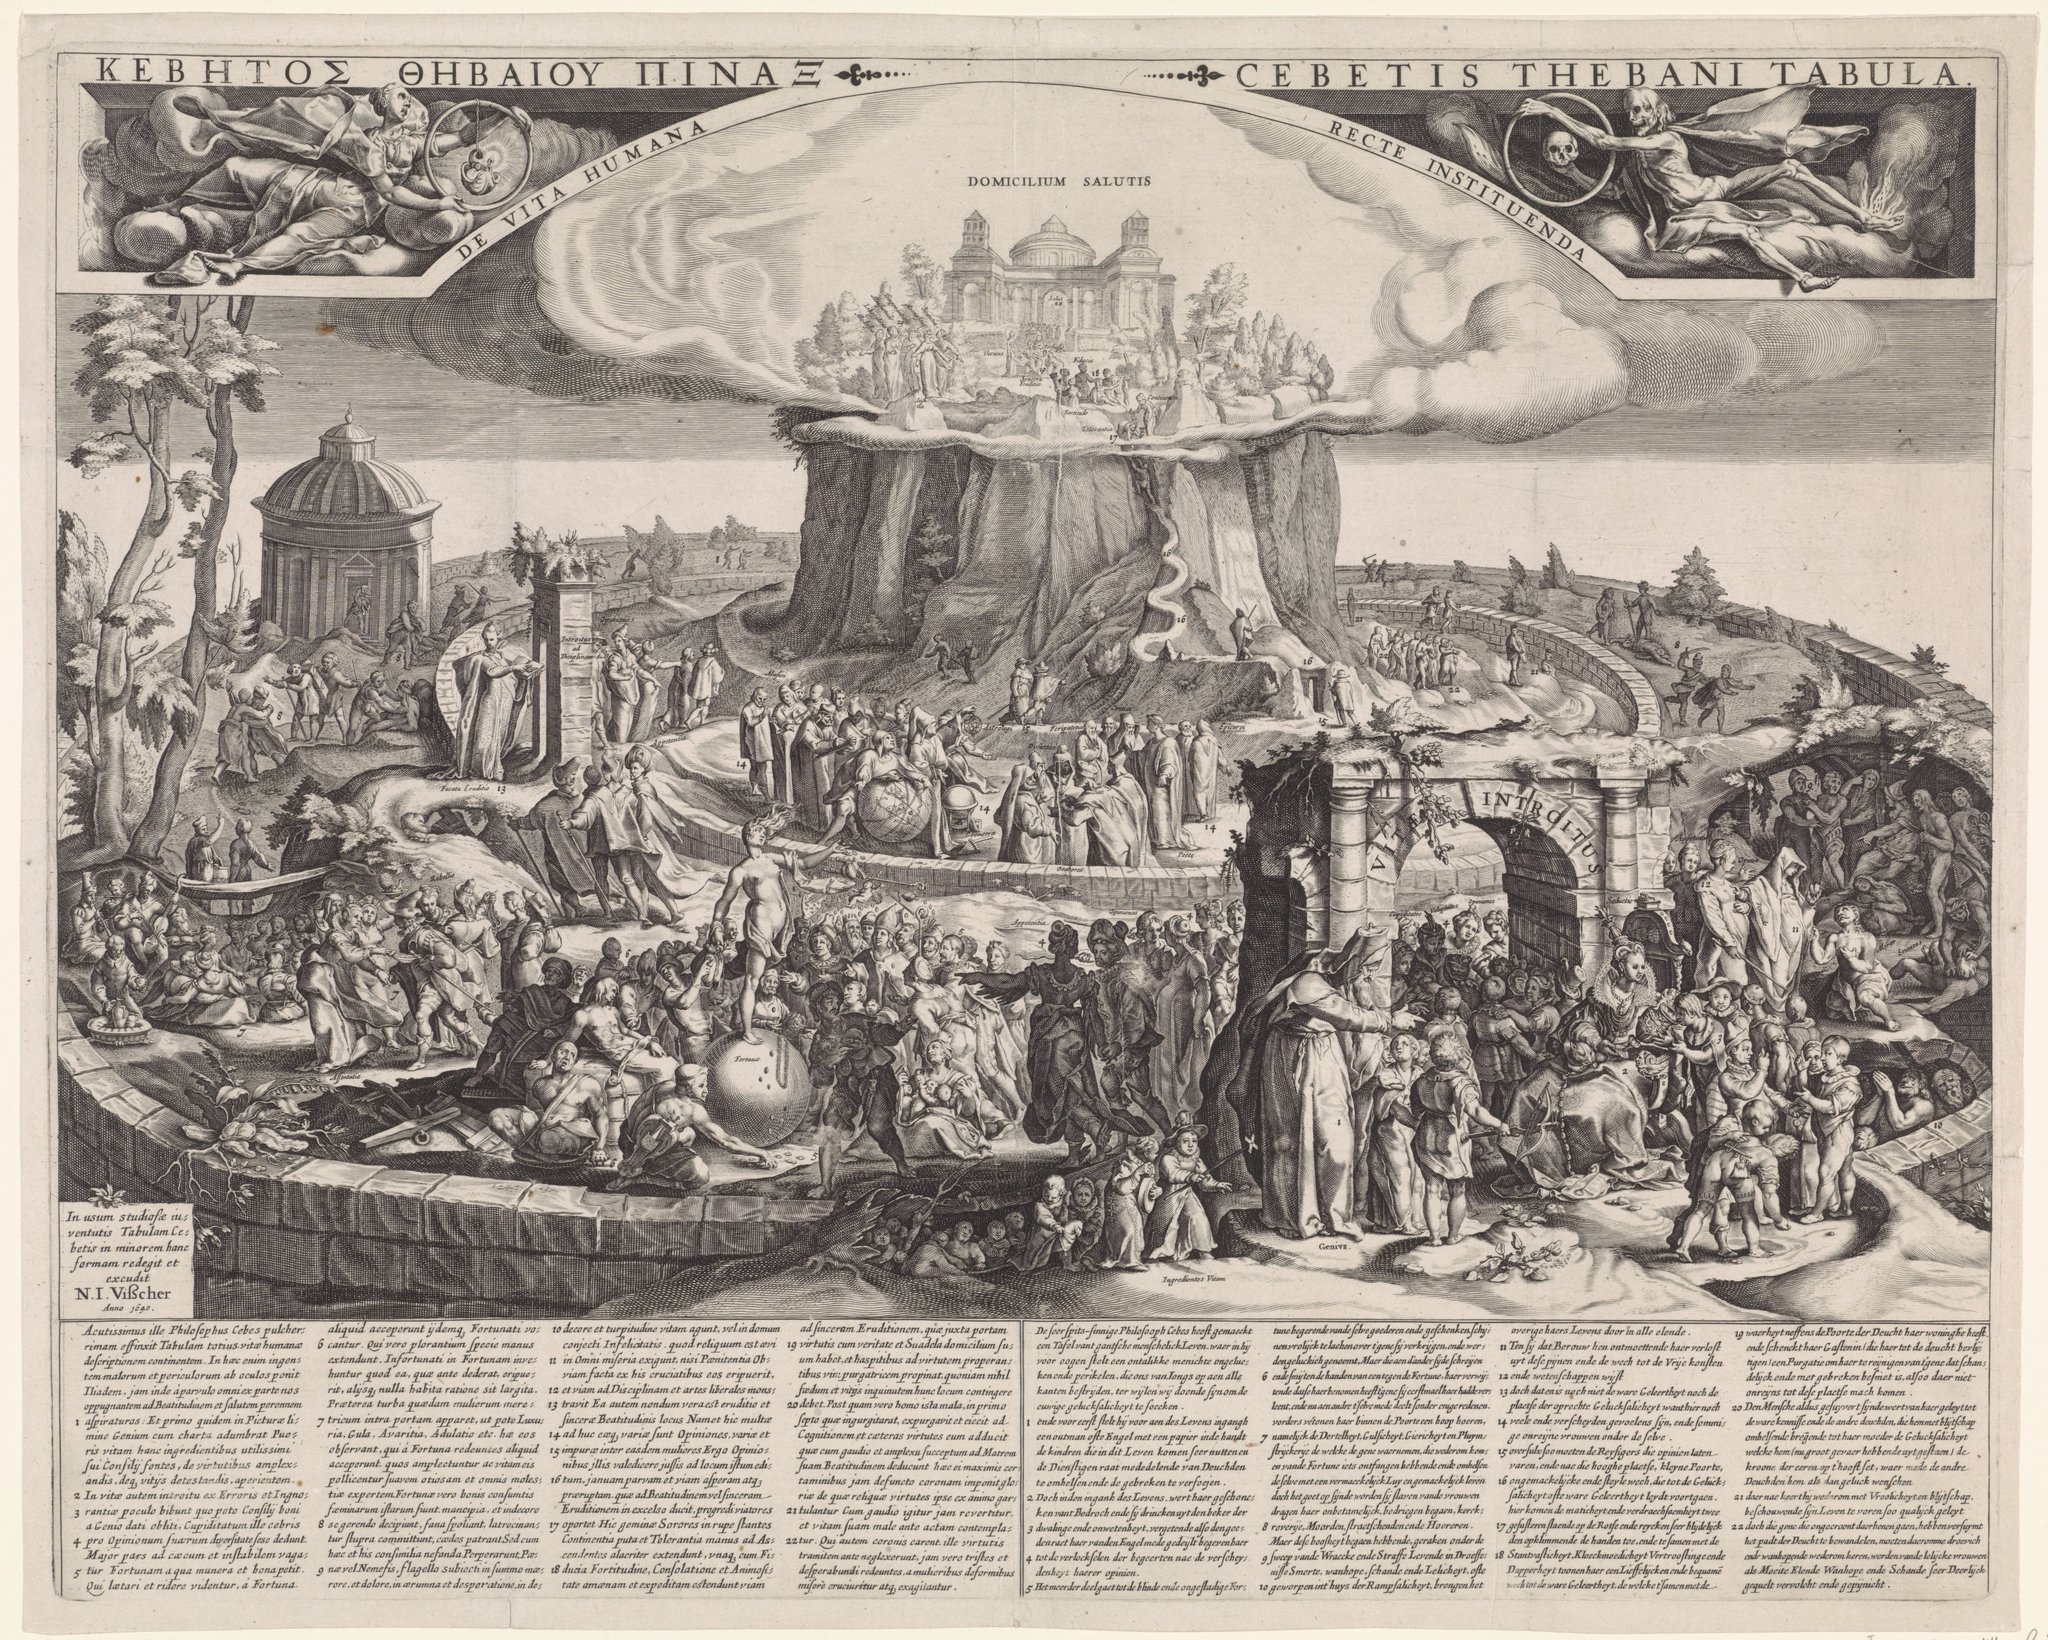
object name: print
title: Cebetis Thebani Tabula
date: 1640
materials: paper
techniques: engraving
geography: amsterdam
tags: 'tabula cebetis'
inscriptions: collector's mark: Lugt 2228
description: Tafel van Cebes. Allegorische voorstelling van de levensweg als de passage door concentrische ringen naar de tempel van geluk op een berg in het midden. Gedetailleerde voorstelling met talloze personen en allegorische figuren met opschriften. Onder de voorstelling een legenda met 22 verwijzingen; links in het Latijn, rechts in het Nederlands.